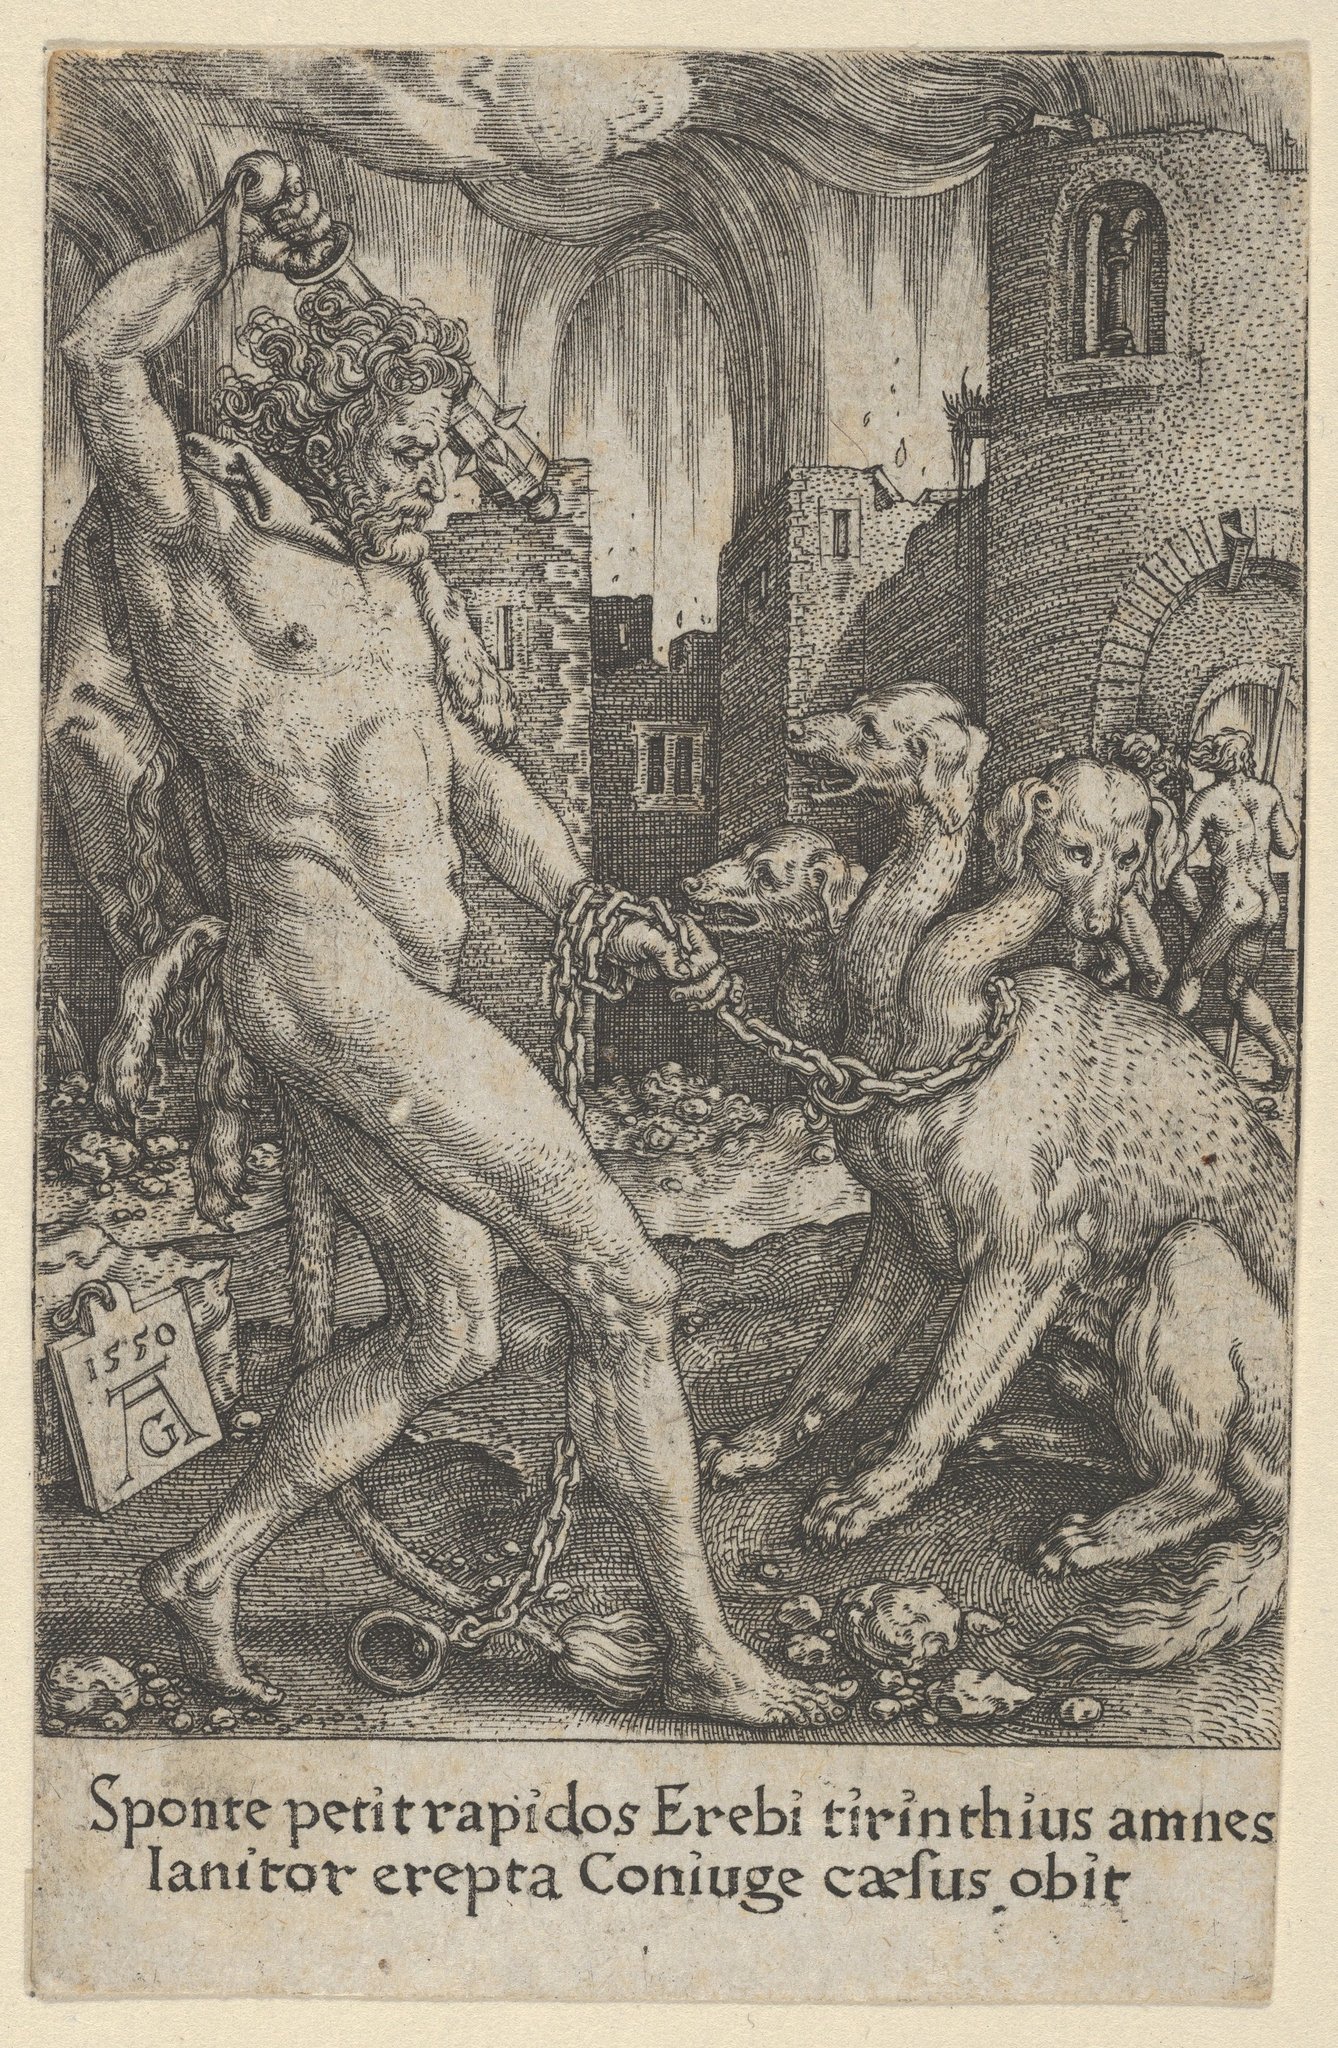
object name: print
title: Hercules and Cerberus, from "The Labors of Hercules"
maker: heinrich aldegrever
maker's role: artist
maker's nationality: german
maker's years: 1502-1561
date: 1550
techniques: engraving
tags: hercules,mythical creatures,dogs